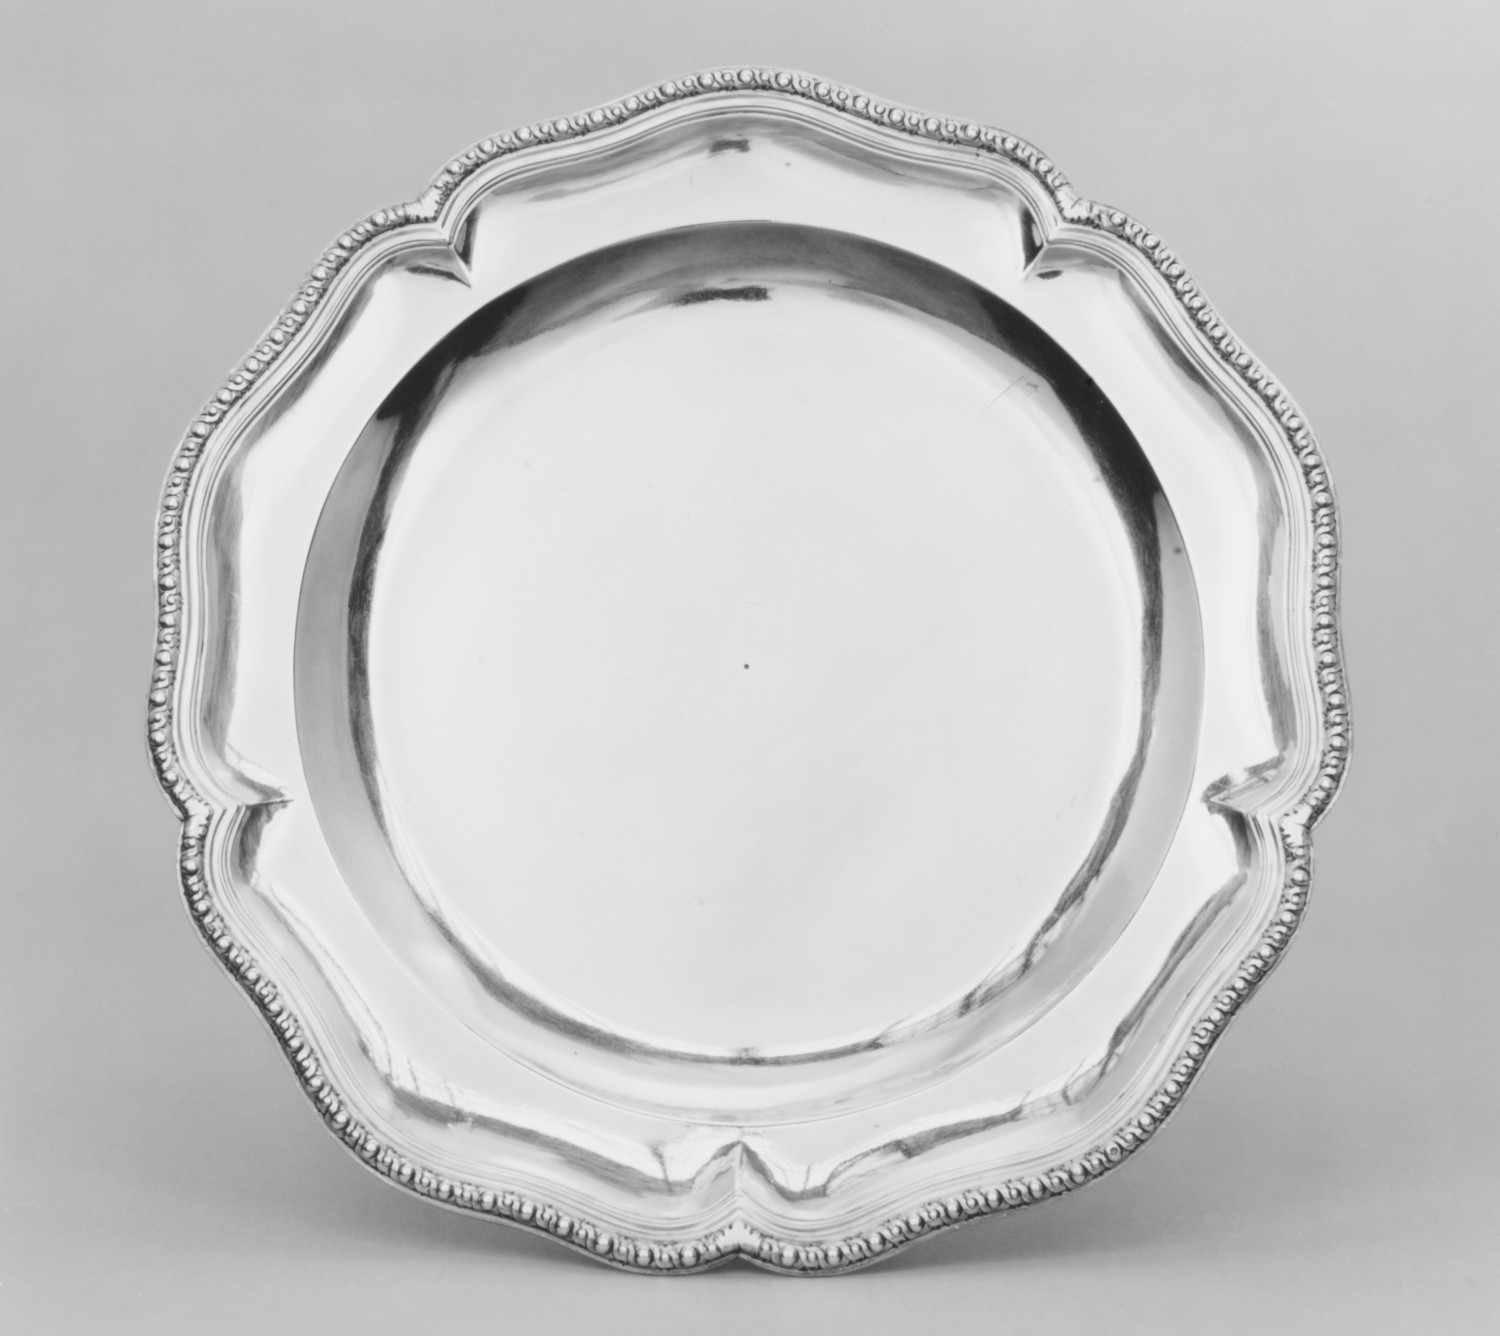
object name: plate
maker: nicolas-clément valliêres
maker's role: maker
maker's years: 1702-1811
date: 1756-1757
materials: silver